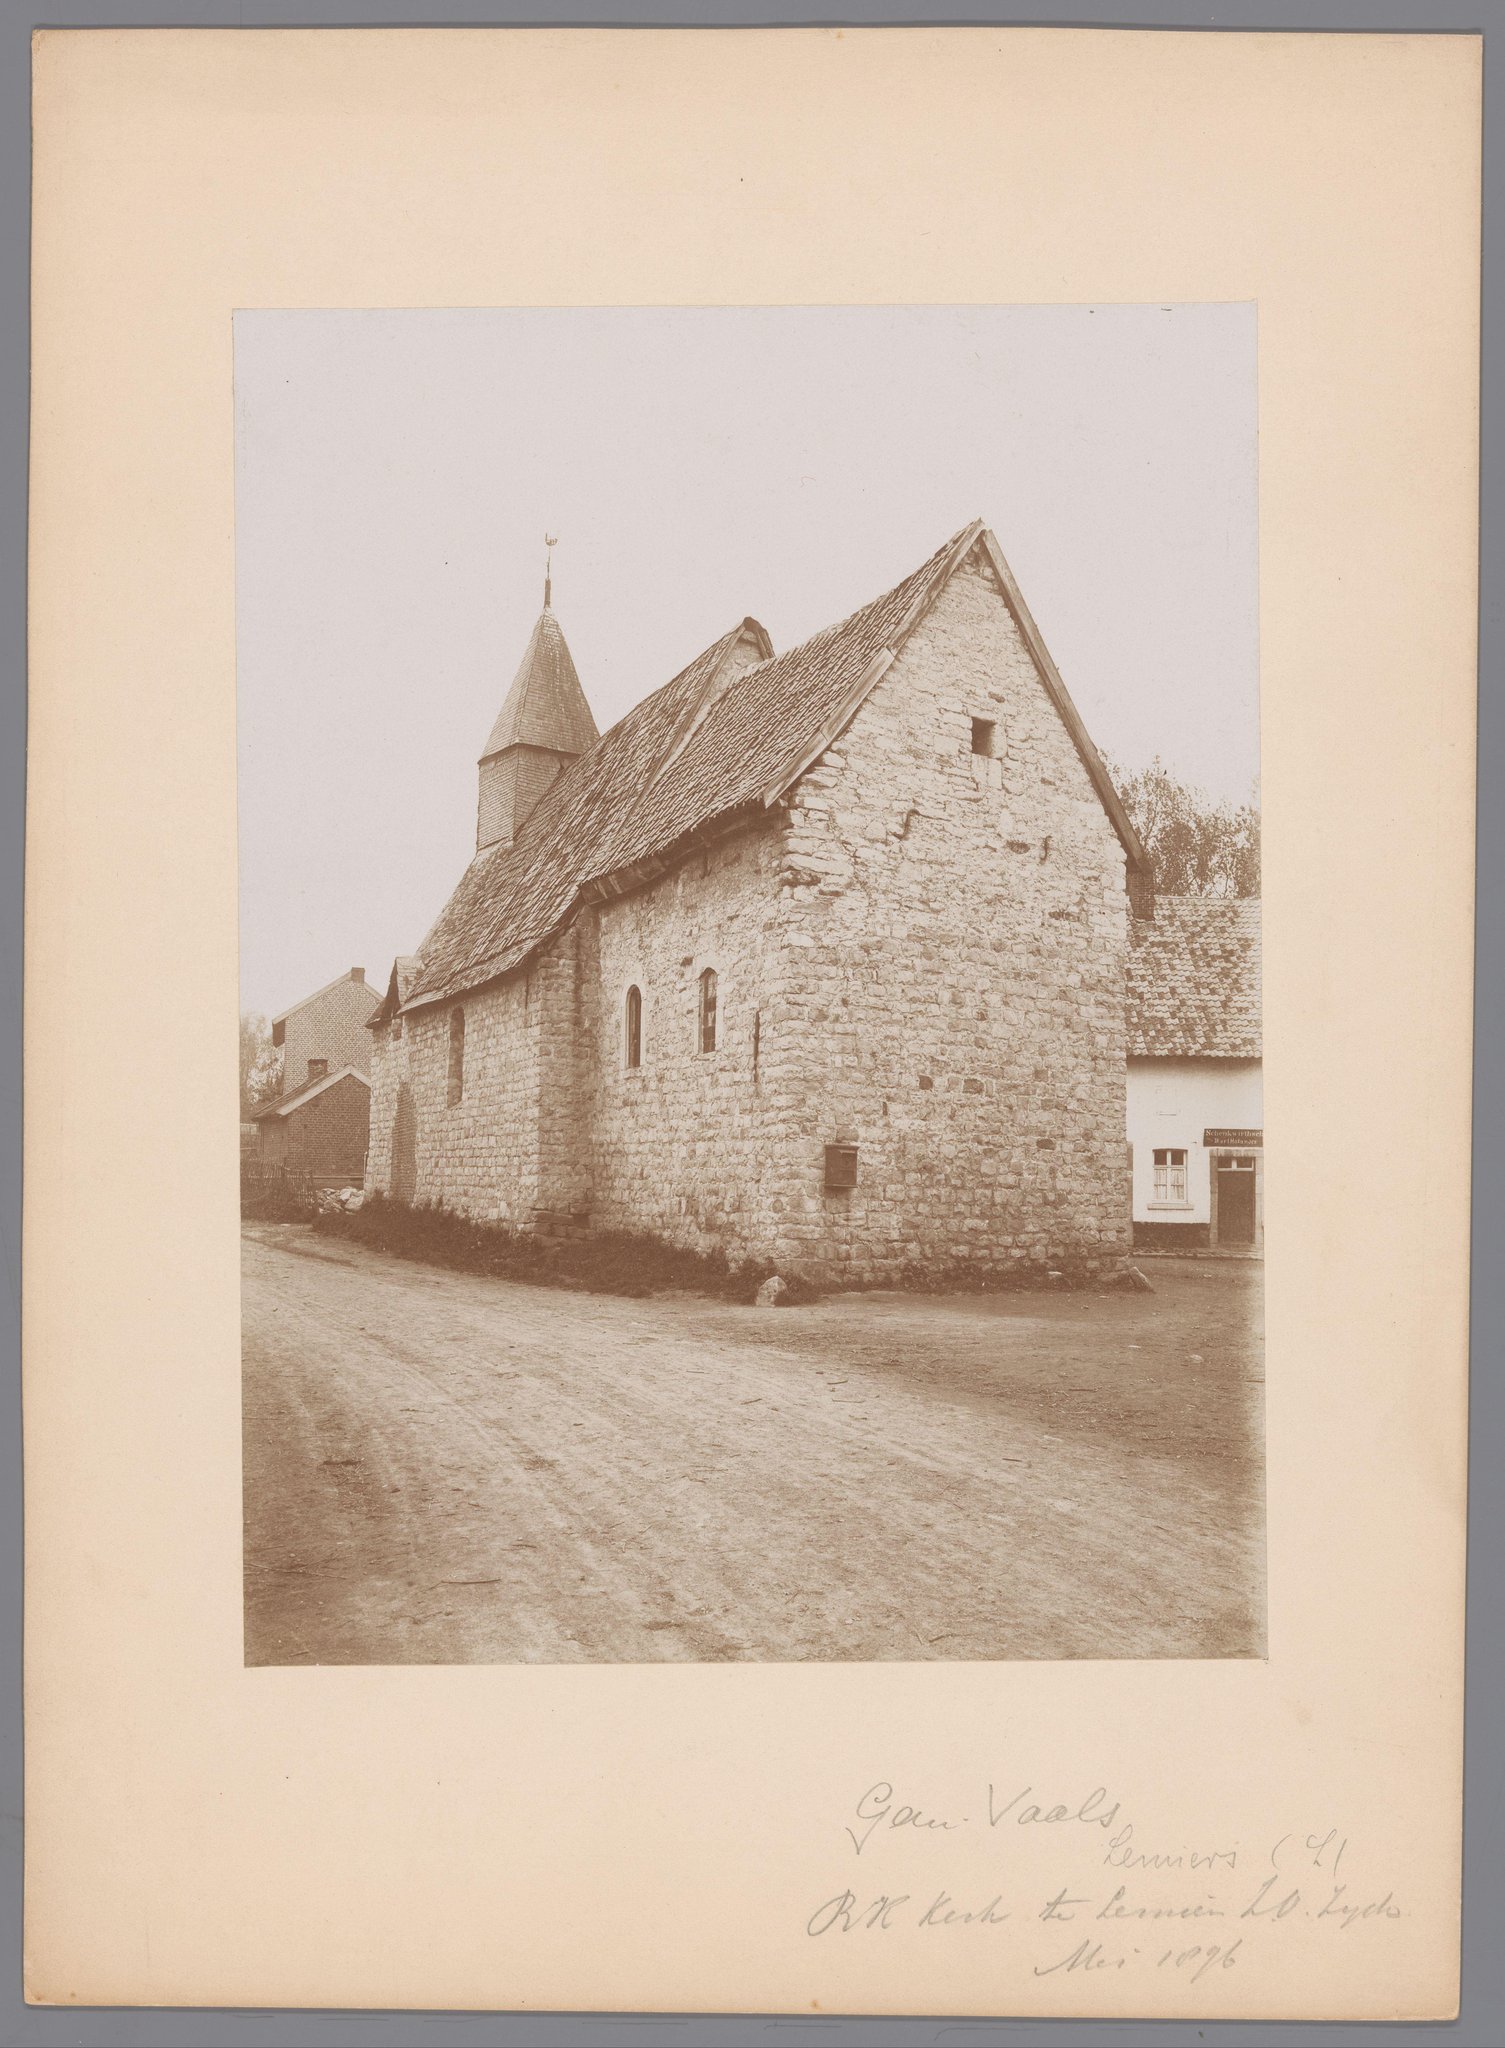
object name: photograph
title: Zuidoostzijde van de Sint-Catharinakapel te Lemiers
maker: anoniem (monumentenzorg)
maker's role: fotograaf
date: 1896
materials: cardboard, photographic support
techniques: collodion silver print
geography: lemiers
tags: church (exterior)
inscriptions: annotation: ‘Lemiers (L)/ R.K. kerk’, annotation: ‘gem. Vaals Lemiers (L)/ R.K. kerk te Lemiers Z.O. zijde/ Mei 1896’